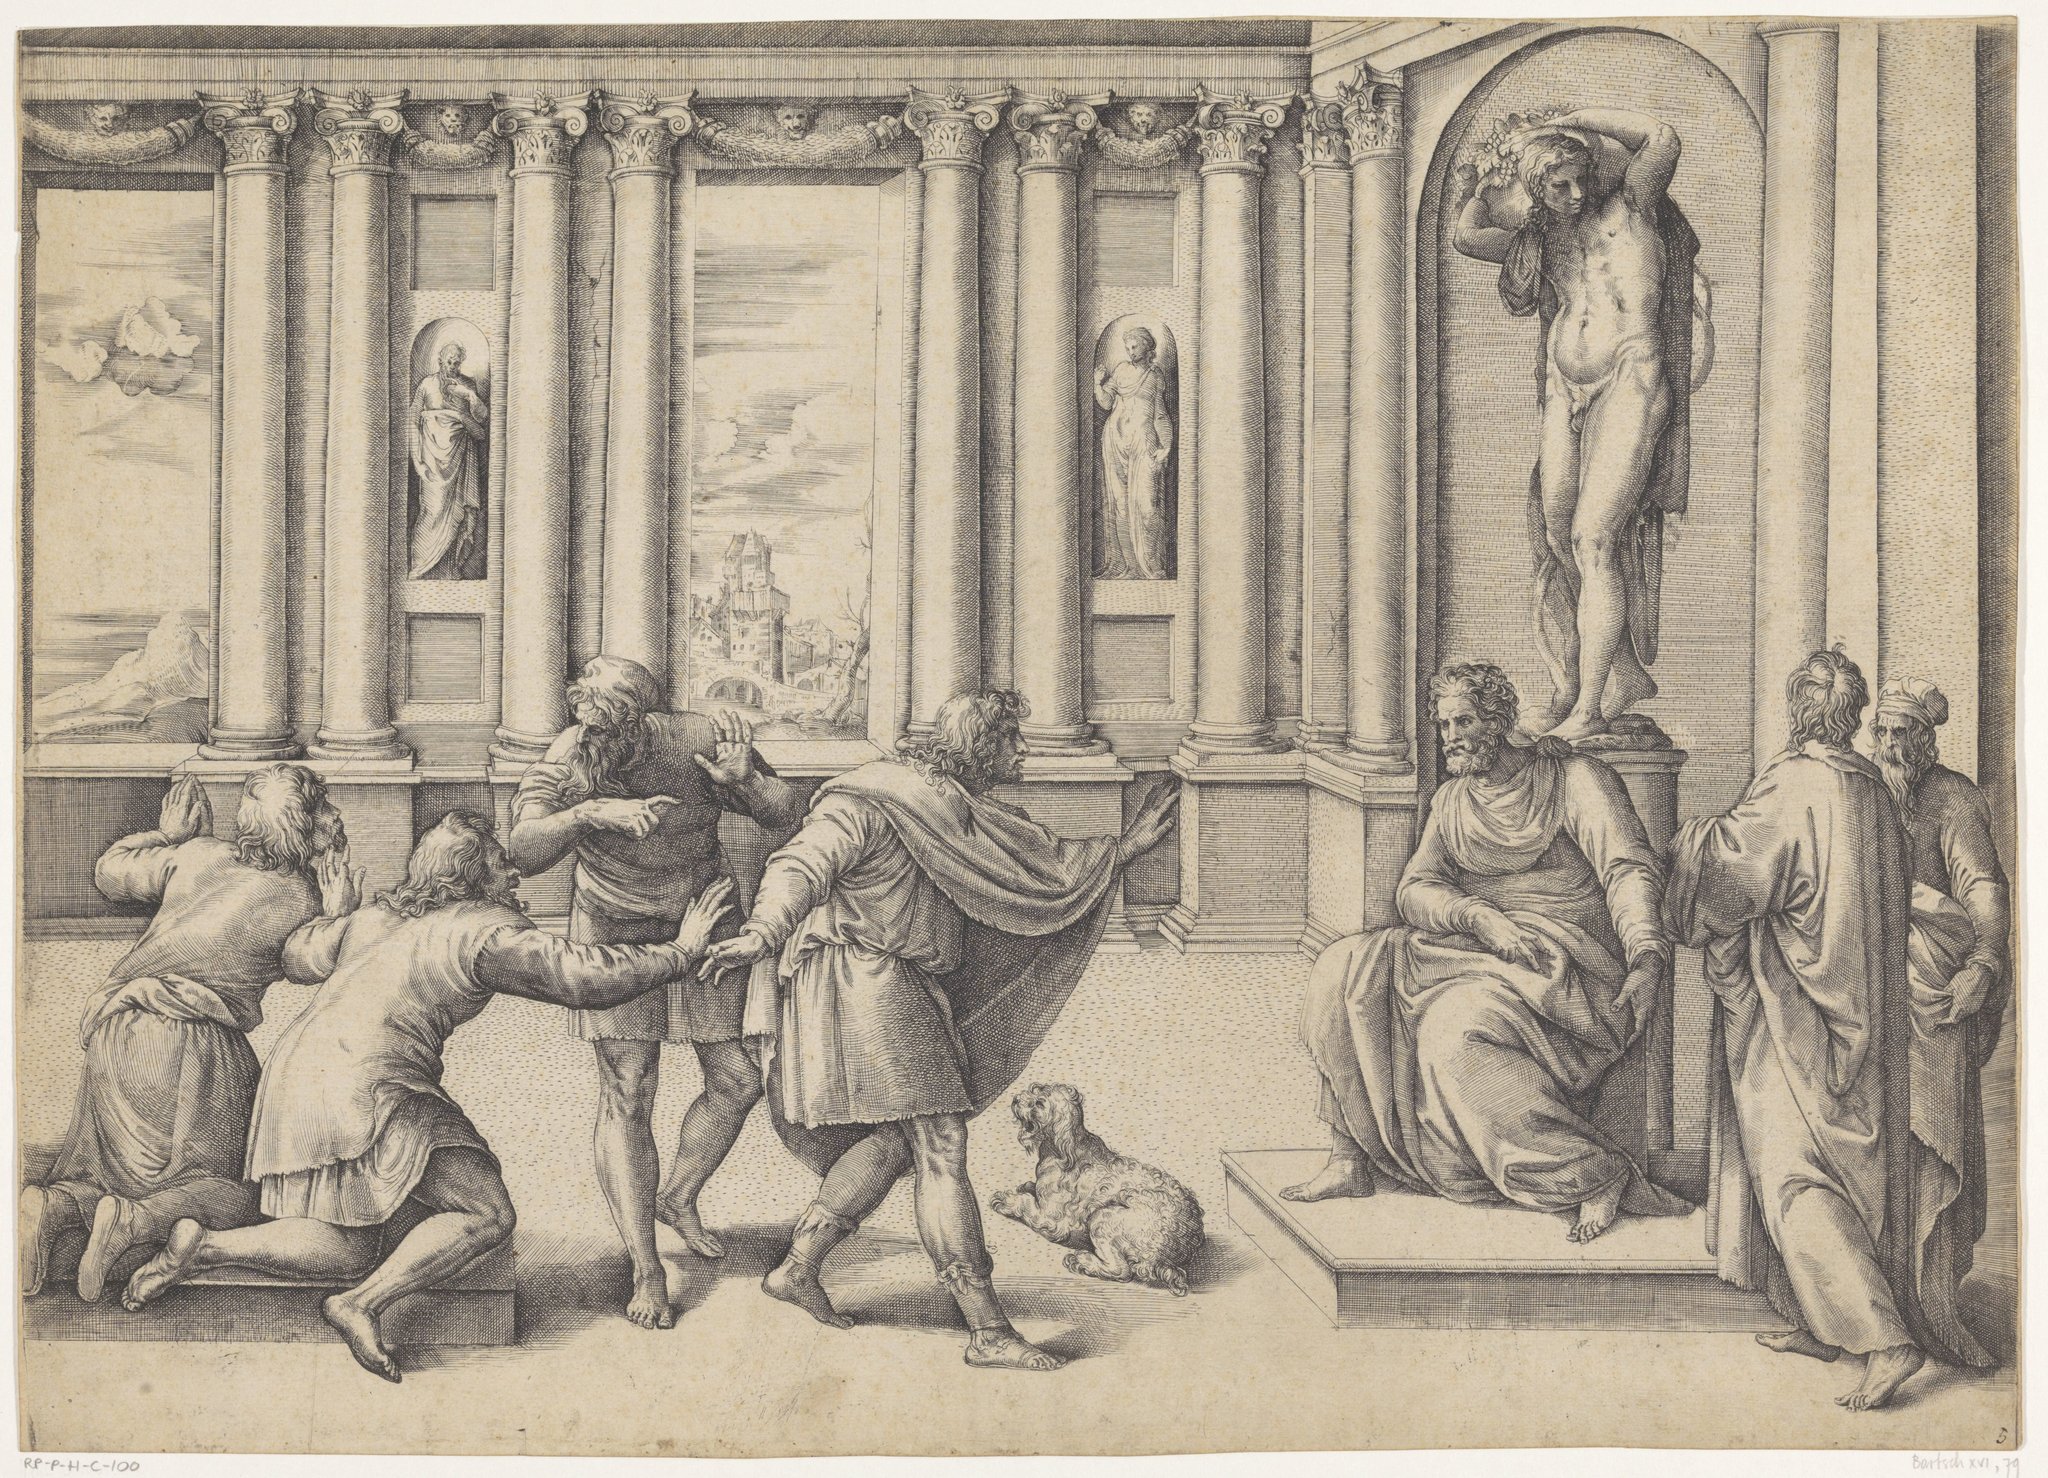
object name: print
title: Mannen op audiëntie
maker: battista franco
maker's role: draughtsman, painter, print maker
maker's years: 1510-1561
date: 1520-1561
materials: paper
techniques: engraving, etching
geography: italy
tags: audition; ruler giving audience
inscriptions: collector's mark: Lugt 10, collector's mark: Lugt 11, number:, collector's mark: ‘Hinloopen’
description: Zicht in een paleiszaal met een man, zittend voor een beeld van de wijngod Bacchus. Voor de man een groep van vier mannen op audiëntie en een hond.